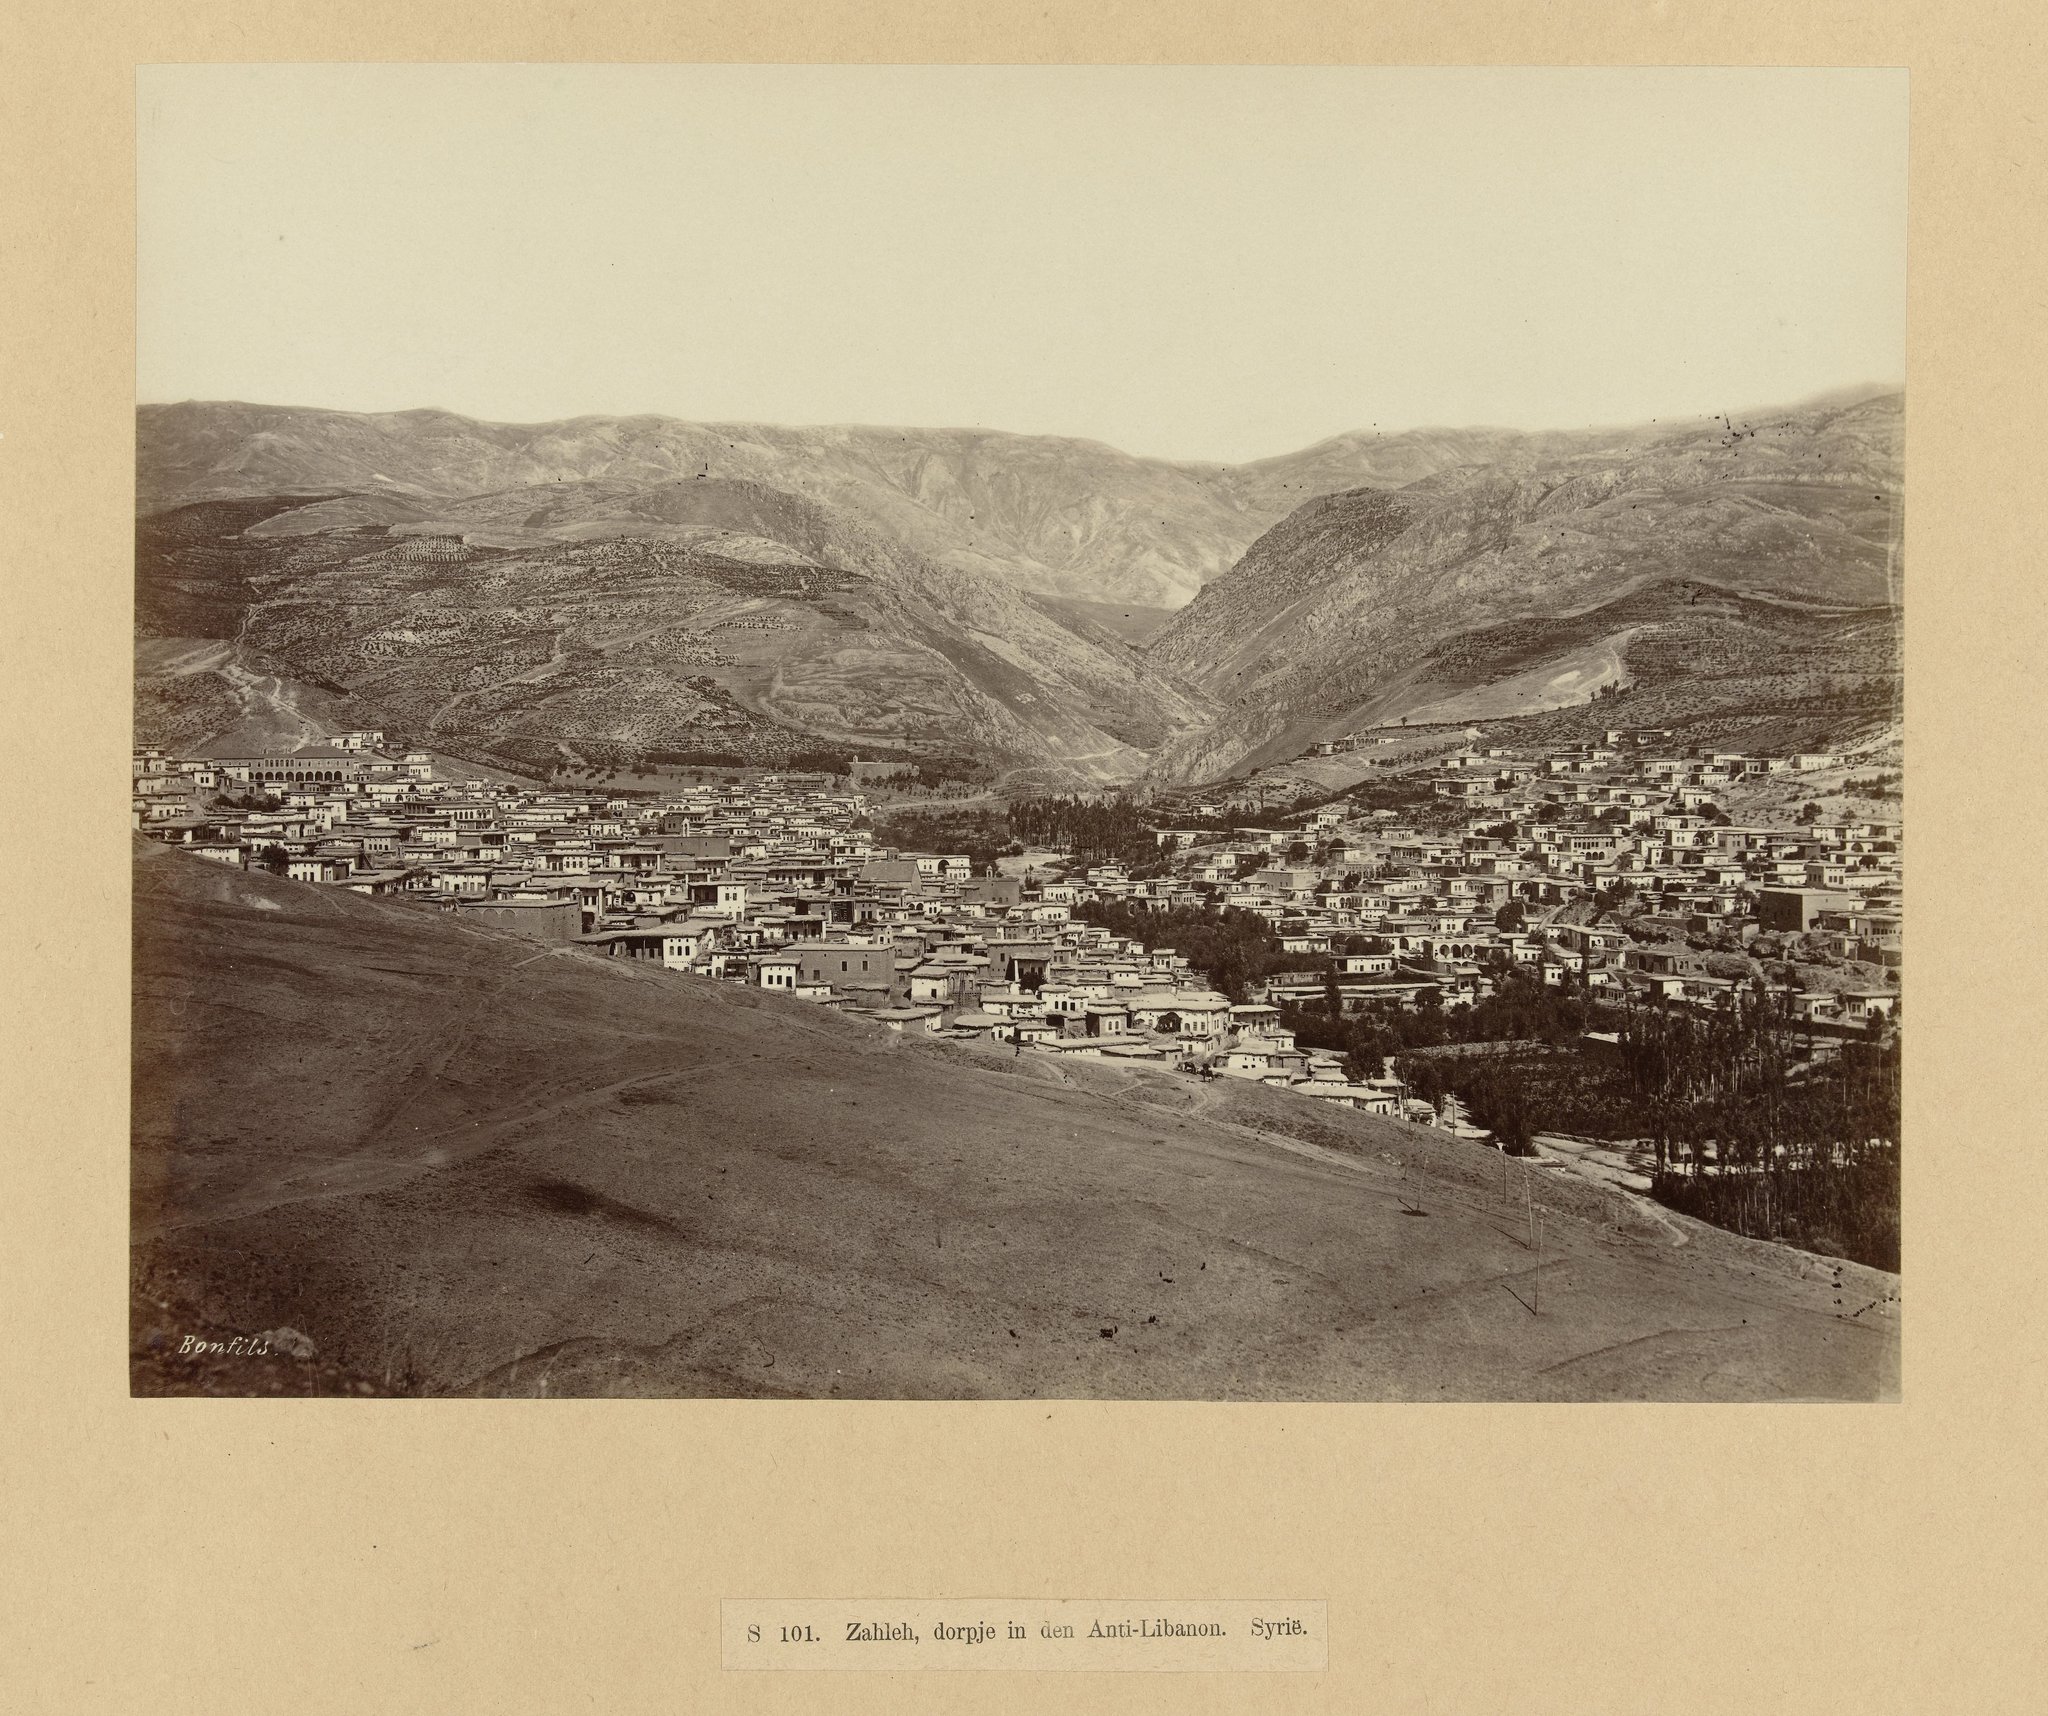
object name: photograph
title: S 101. Zahleh, dorpje in den Anti-Libanon. Syrië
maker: félix bonfils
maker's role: fotograaf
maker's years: 1831-1885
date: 1867-1877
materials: cardboard, paper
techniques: albumen print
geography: ottoman empire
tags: prospect of village, silhouette of village, mountains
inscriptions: stamp: ‘Gemeentelijke bibliotheek/ Rotterdam’, title: ‘S 101. Zahleh, dorpje in den Anti-Libanon. Syrië.’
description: Onderdeel van een groep door fotograaf Richard Polak op reis verzamelde foto’s. Deze foto is samen met andere op zijn reizen verzamelde foto's tentoongesteld bij de Rotterdamsche Kunstkring (1895), Arti en Amicitiae te Amsterdam (1897-1898?) en Societeit 't Collegie te Kampen (datum vooralsnog onbekend).